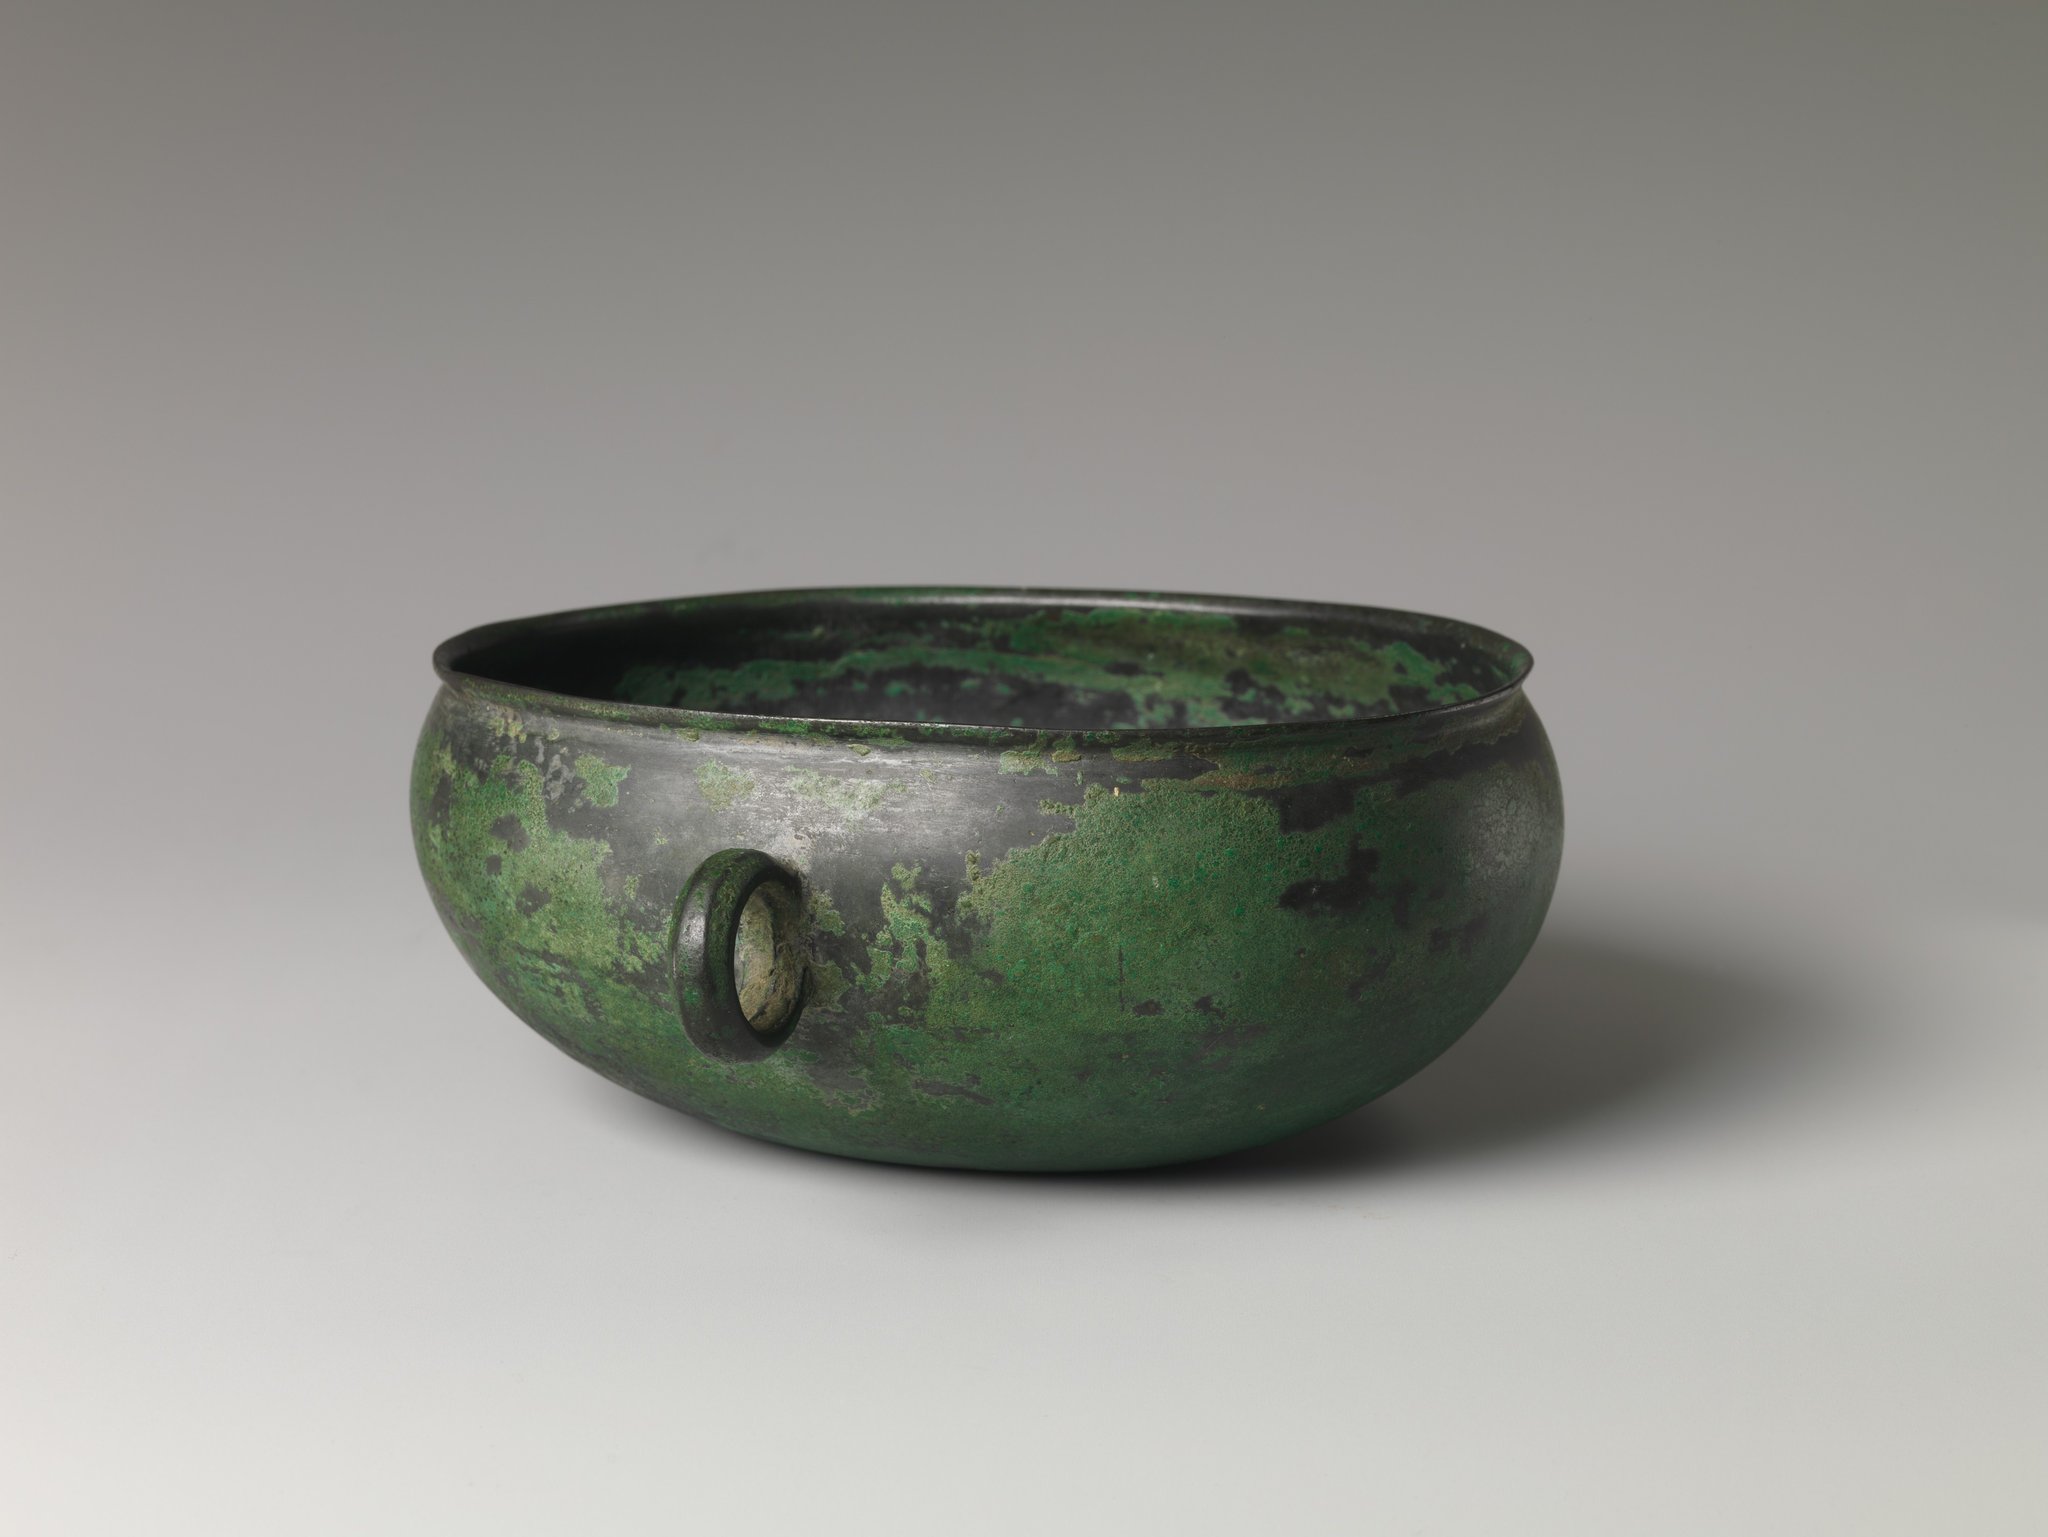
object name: wine cup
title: Wine cup with ring handle (He)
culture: chinese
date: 206 BCE-220 CE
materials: bronze